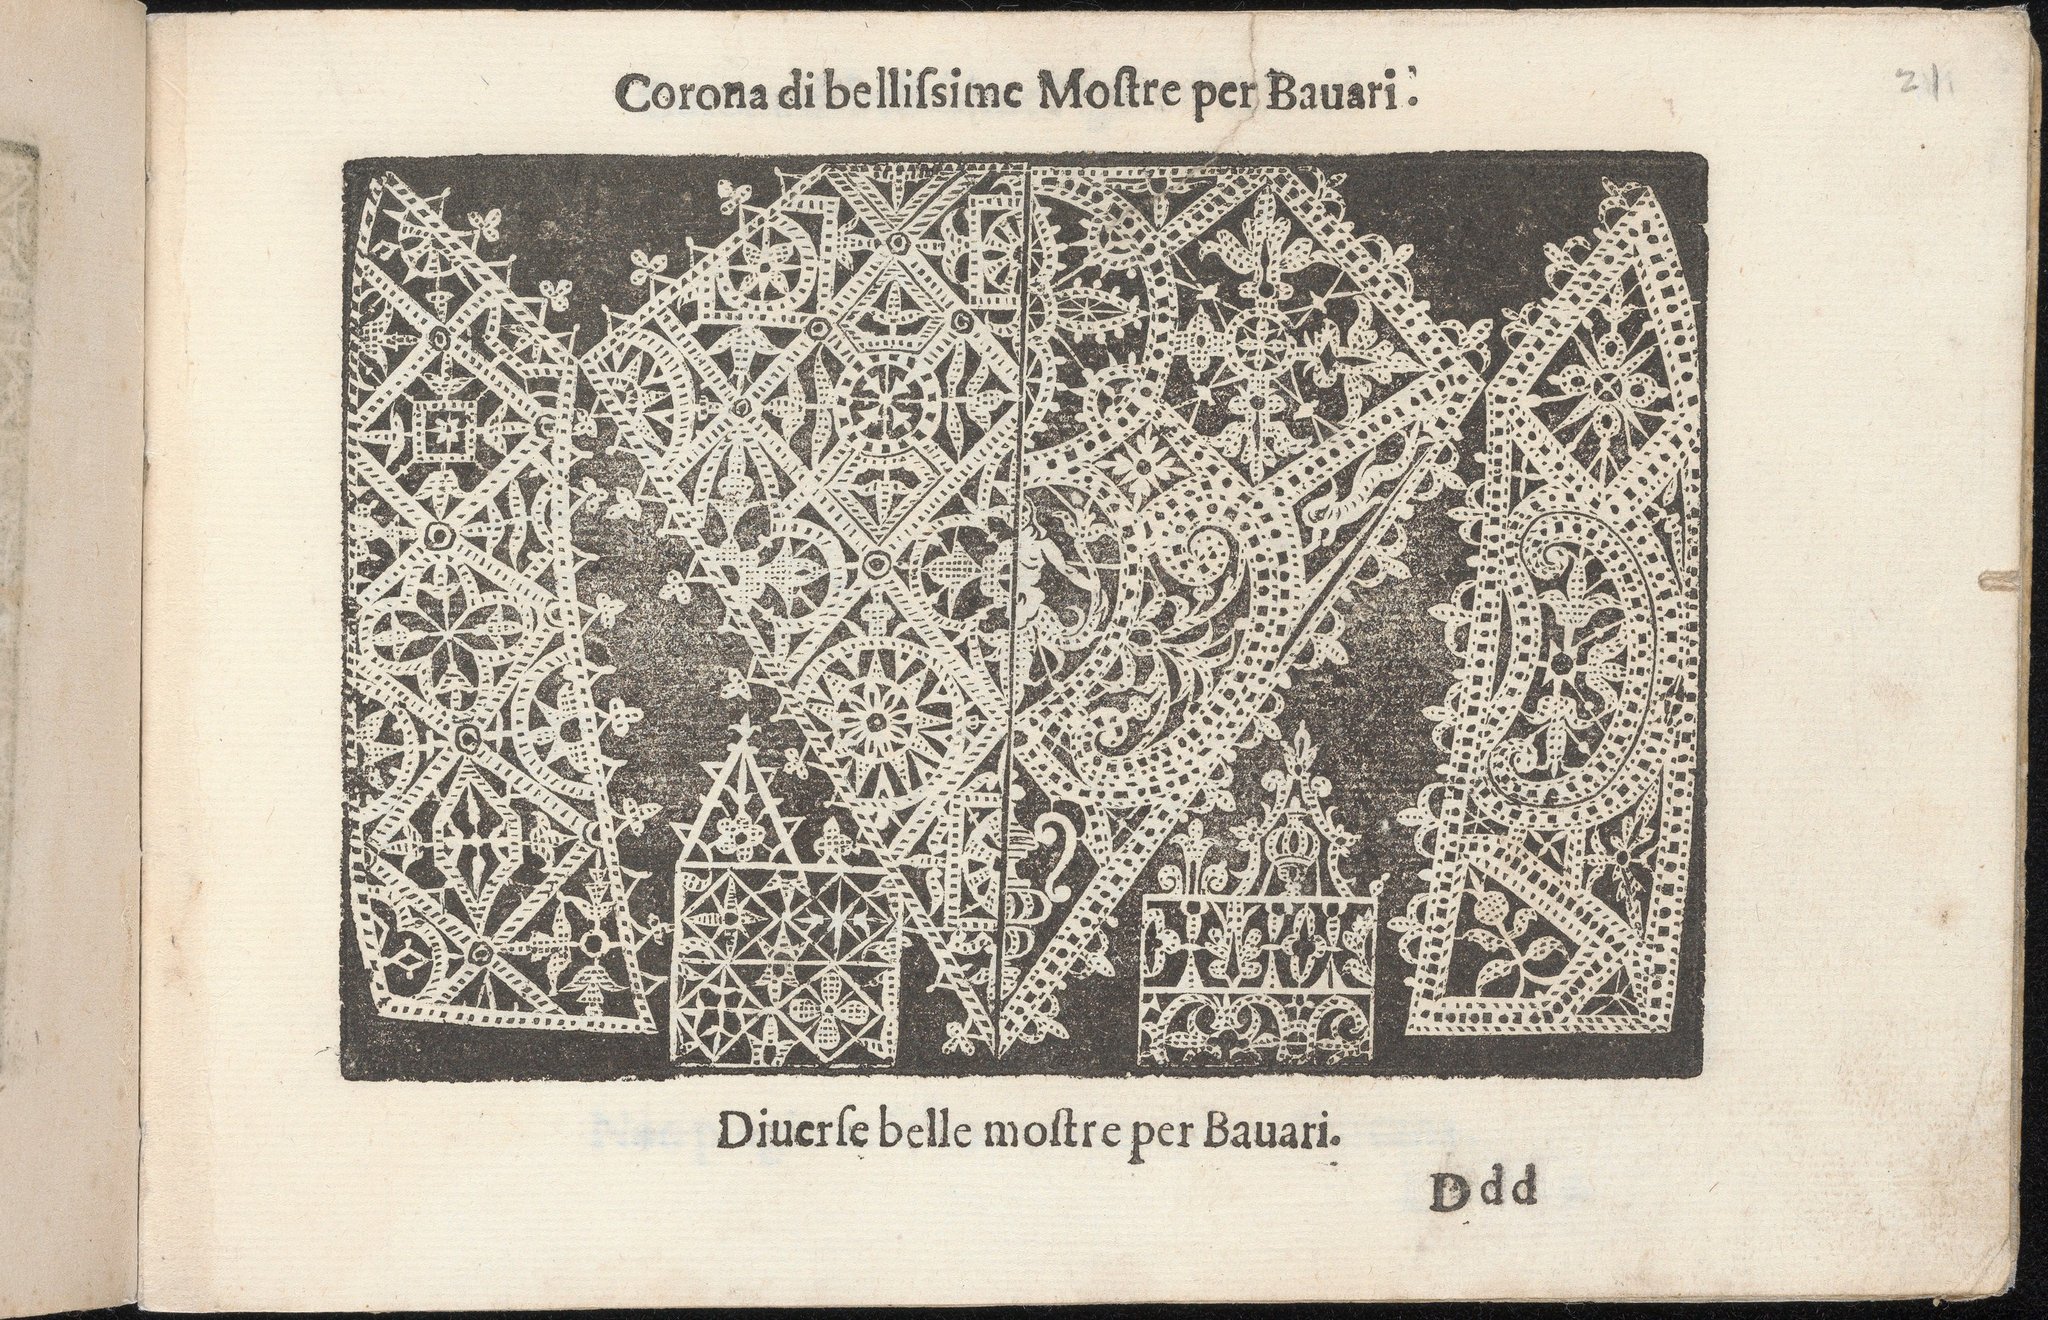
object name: book print ornament architecture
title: Corona delle Nobile et Virtuose Donne, Libro Terzo, page 21 (recto)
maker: cesare vecellio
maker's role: designer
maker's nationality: italian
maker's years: 1521-1601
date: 1620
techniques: woodcut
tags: ornament